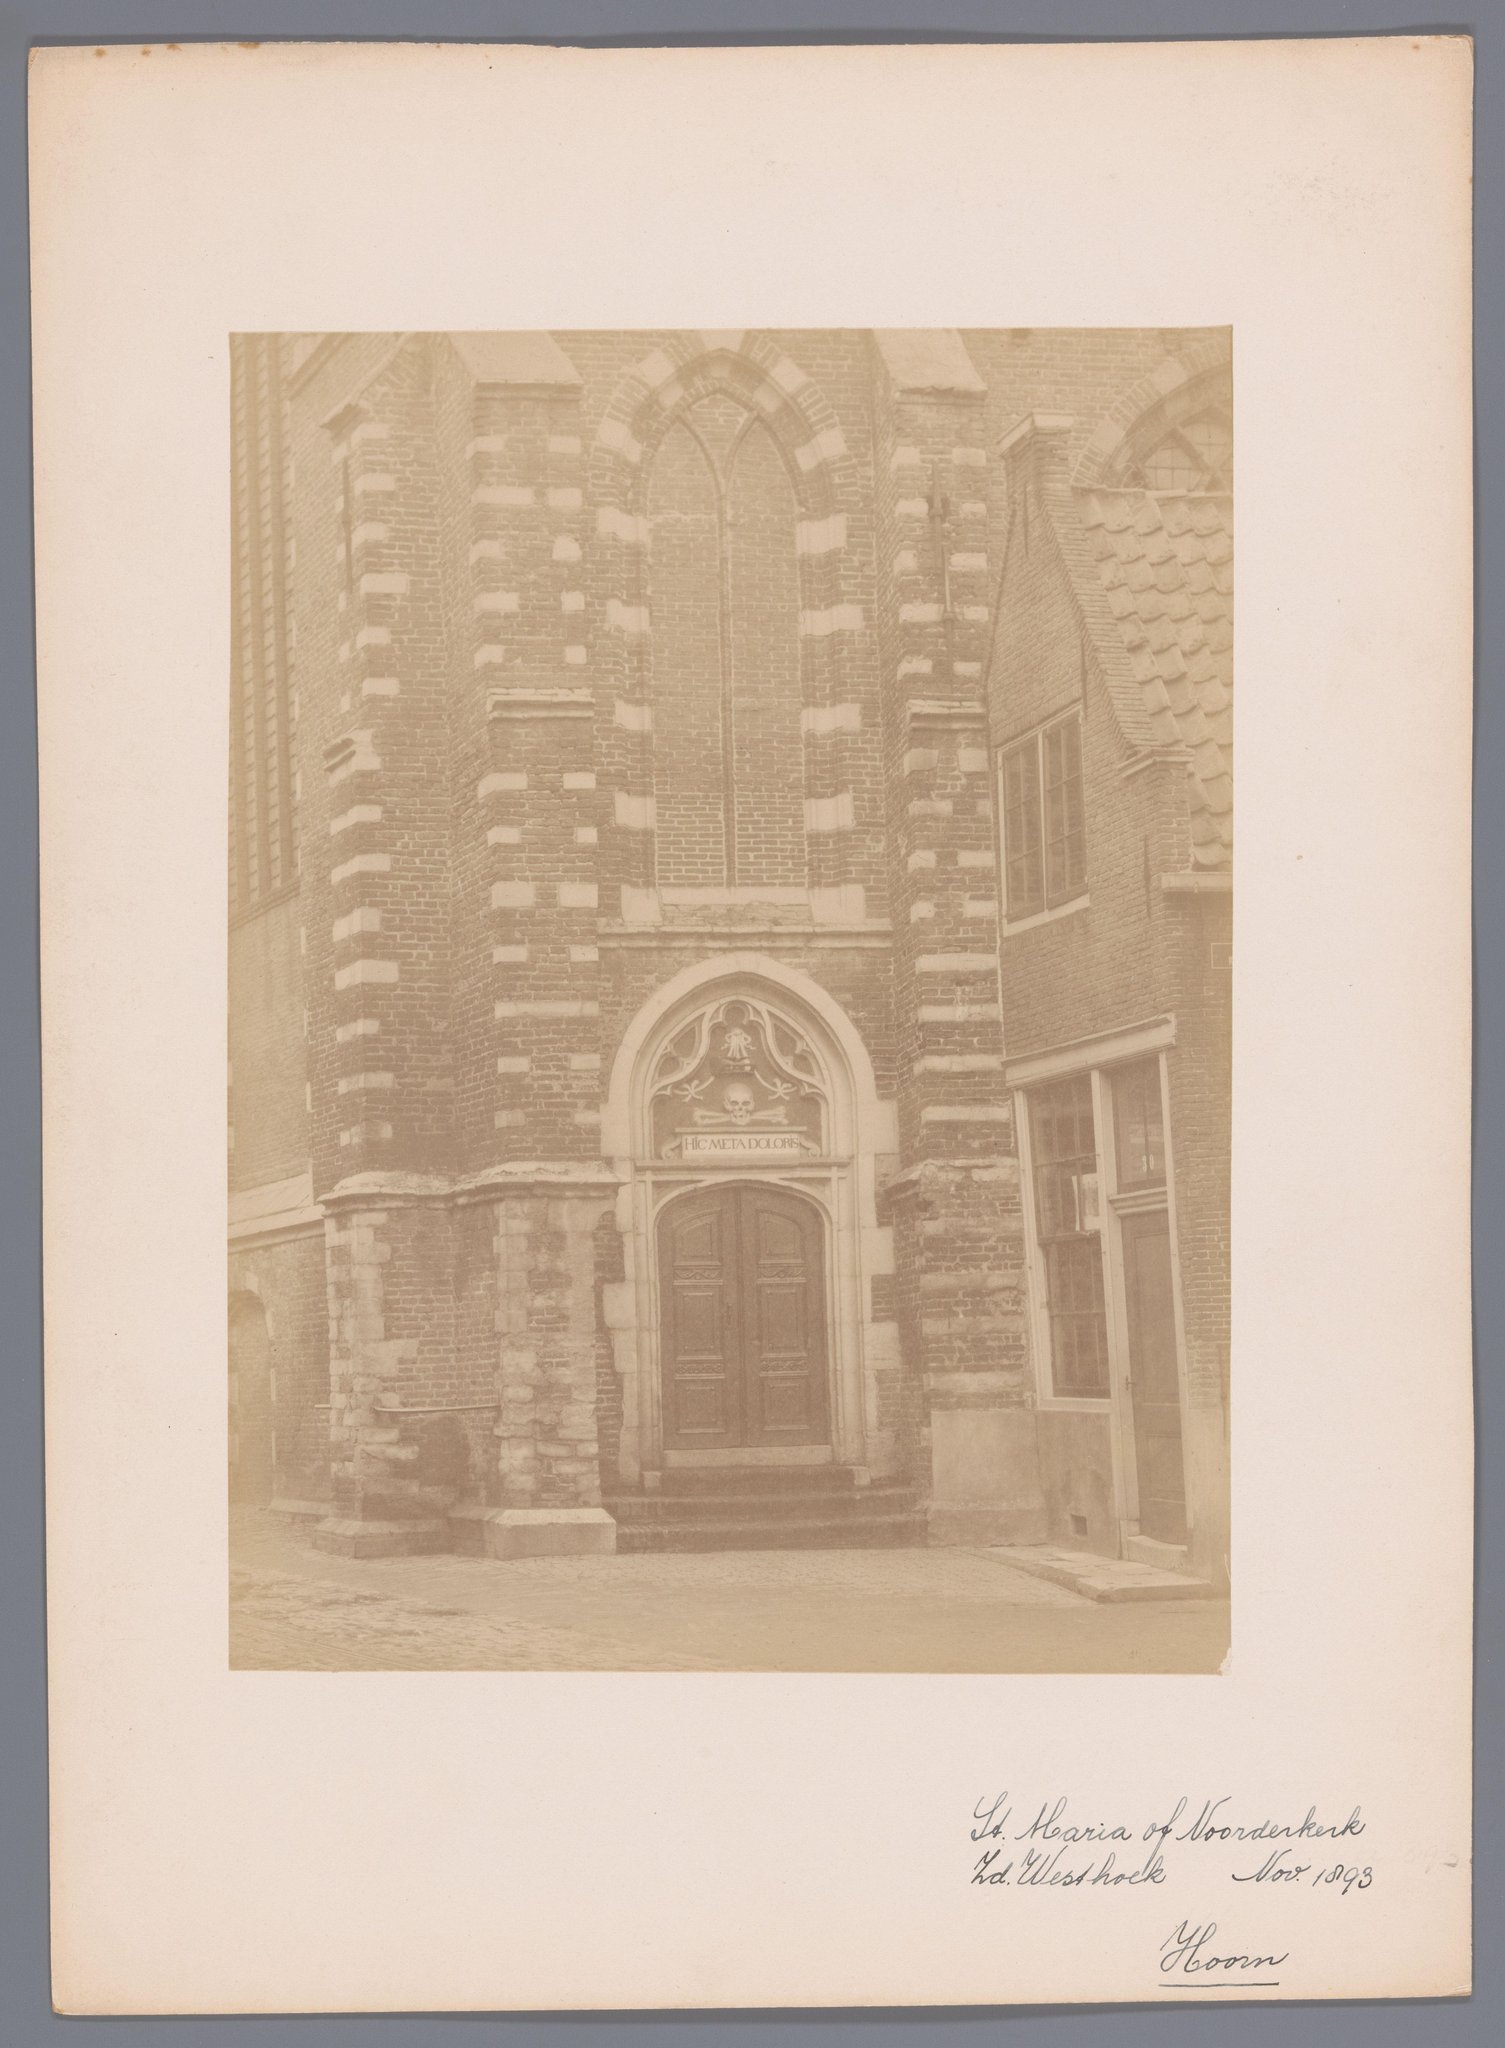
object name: photograph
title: Zuidwest ingang van de Noorderkerk te Hoorn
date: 1893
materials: cardboard, photographic support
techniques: albumen print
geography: hoorn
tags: church (exterior), gate, entrance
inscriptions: annotation: ‘St. Haria of noorderkerk/ Zd. West hoek Nov. 1893/ Hoorn’, annotation: ‘Hoorn (N.H.)/ Zuid-westhoek v/d Noorderkerk/ Nov. 1893’